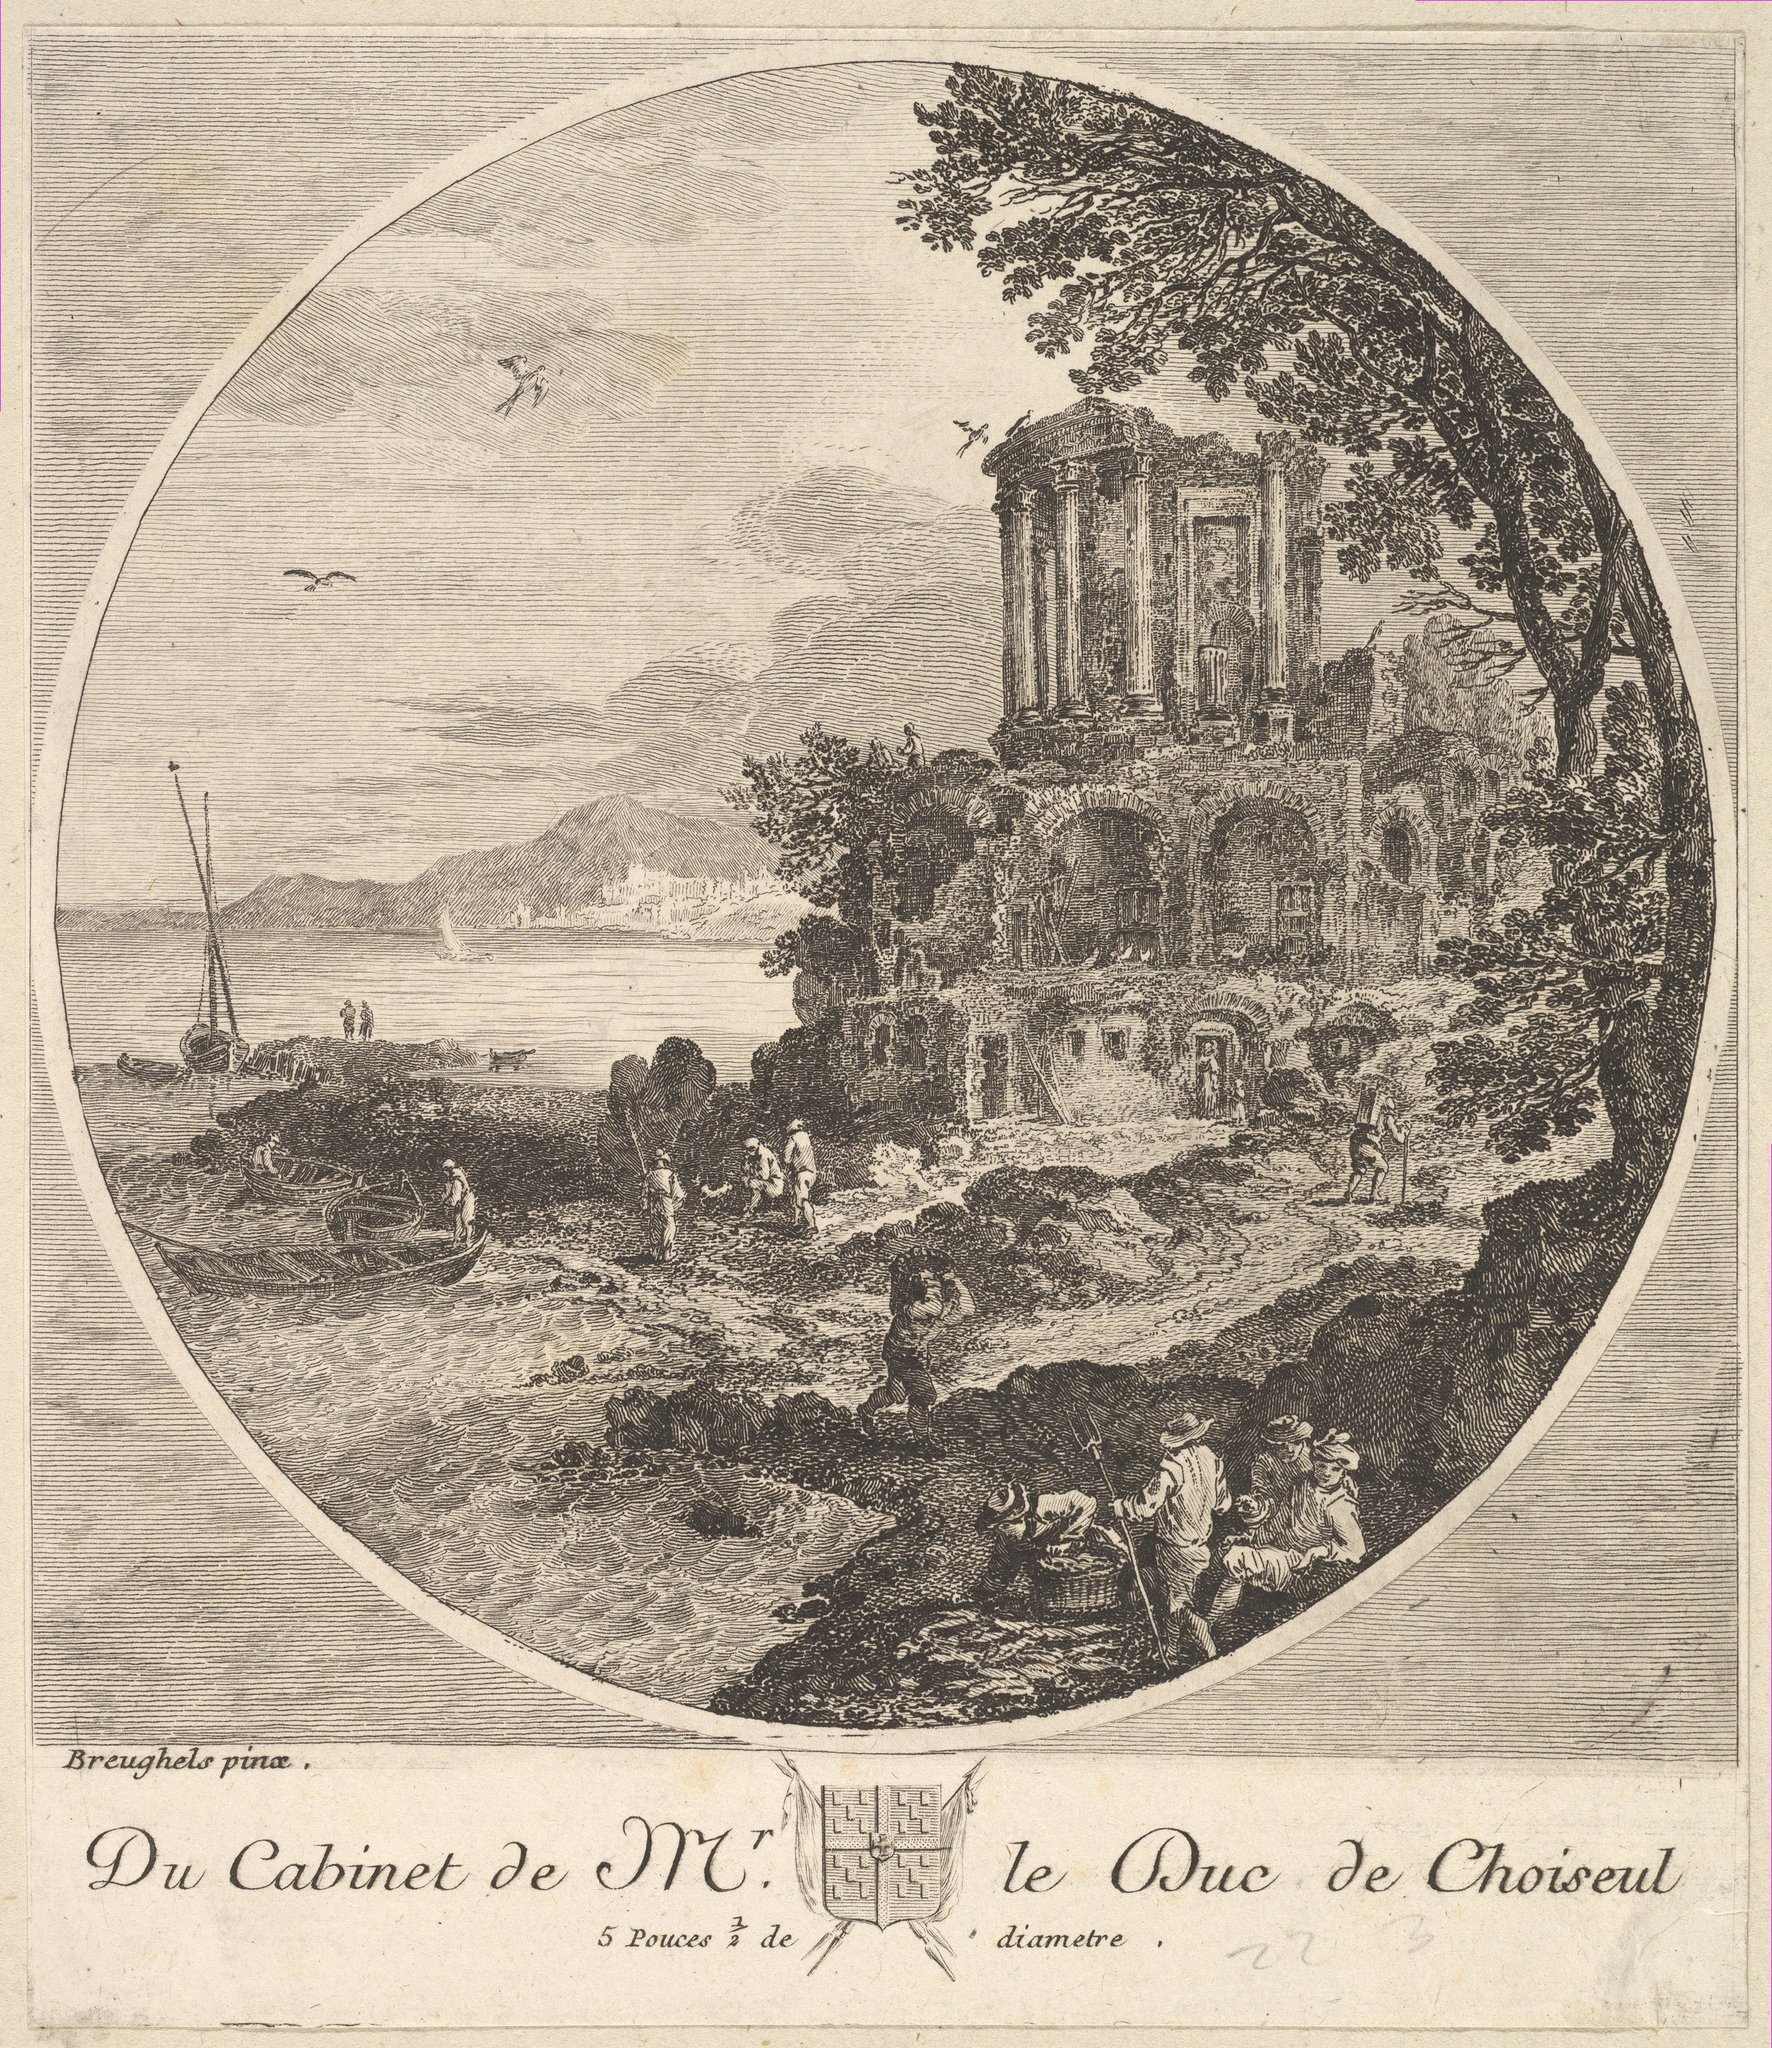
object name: print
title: Seascape with the Ruins of the Temple of the Sybil at Tivoli after a painting in the cabinet of the Duc de Choiseul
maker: anonymous, french, 18th century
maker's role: artist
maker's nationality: french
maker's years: 1700-1800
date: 1700-1790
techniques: engraving, etching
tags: ruins,boats